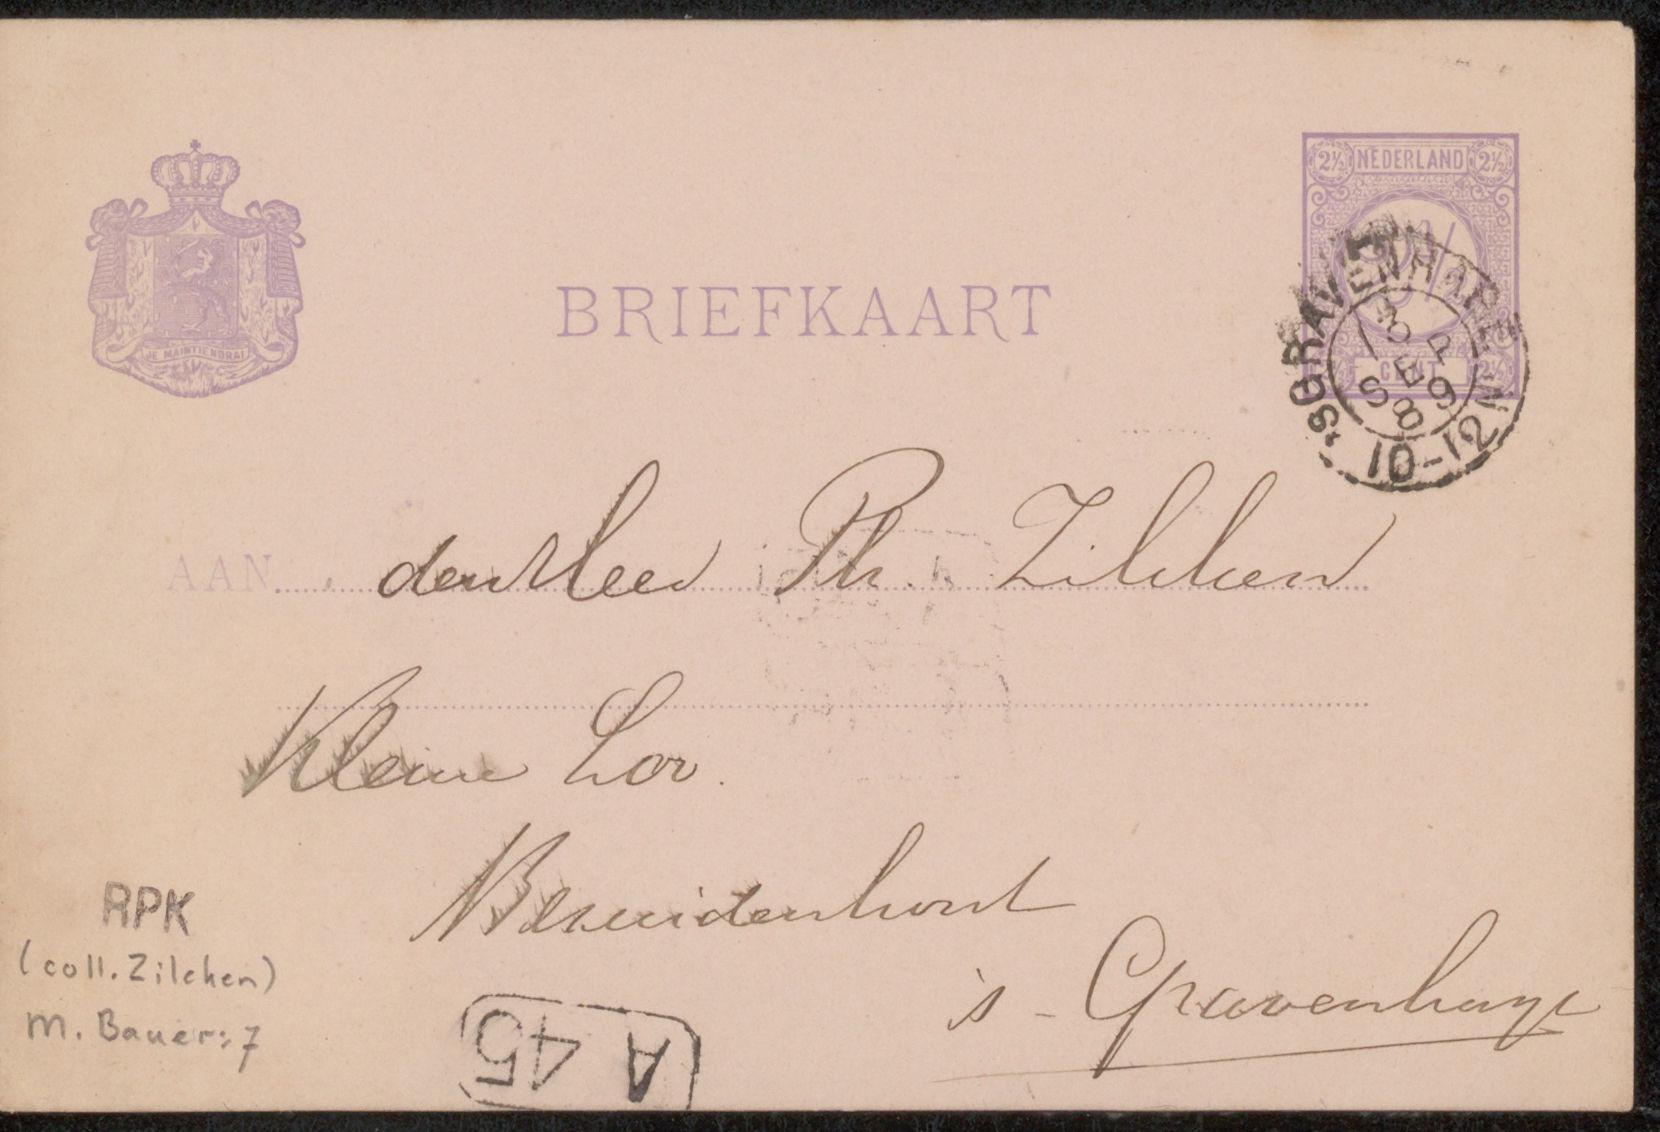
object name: postcard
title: Briefkaart aan Philip Zilcken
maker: marius bauer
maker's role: draughtsman, print maker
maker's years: 1867-1932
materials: cardboard, ink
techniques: pen, writing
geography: the hague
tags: the hague, painter, draughtsman, philip zilcken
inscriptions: collector's mark: ‘RPK’